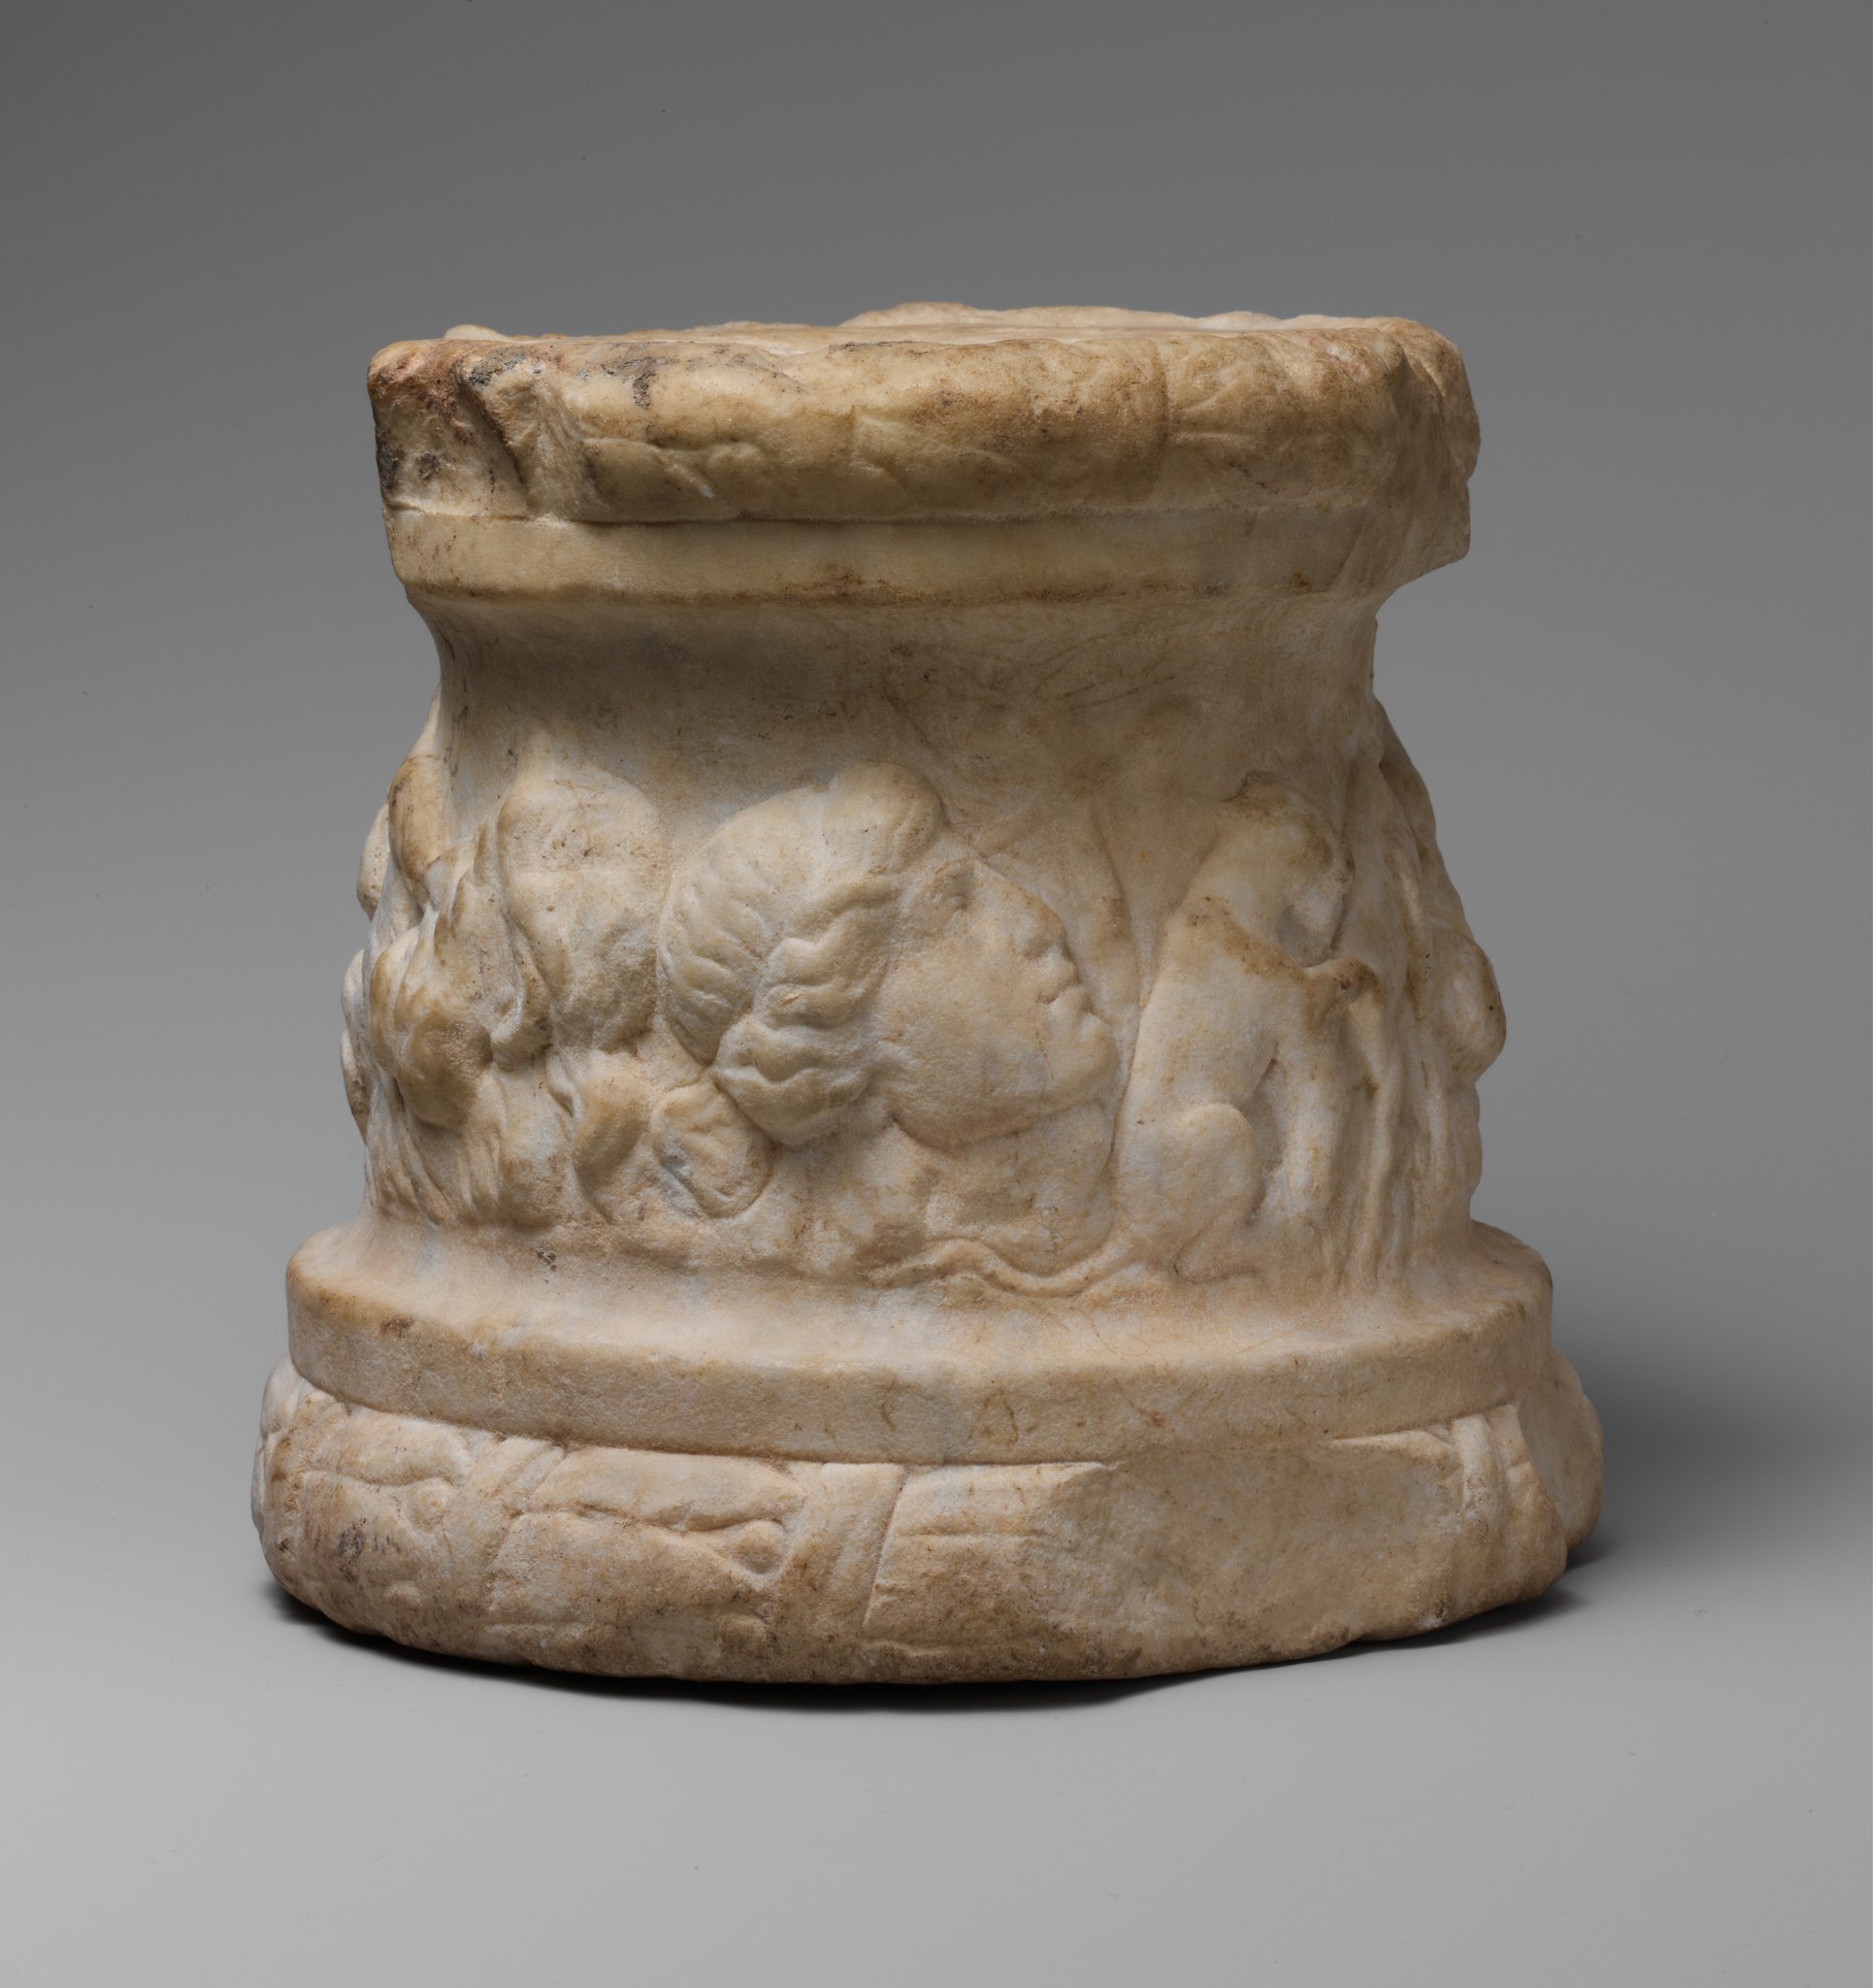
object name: altar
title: Marble round altar with a frieze of animals and masks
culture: roman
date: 1-100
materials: marble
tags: animals,altars,masks,heads,men